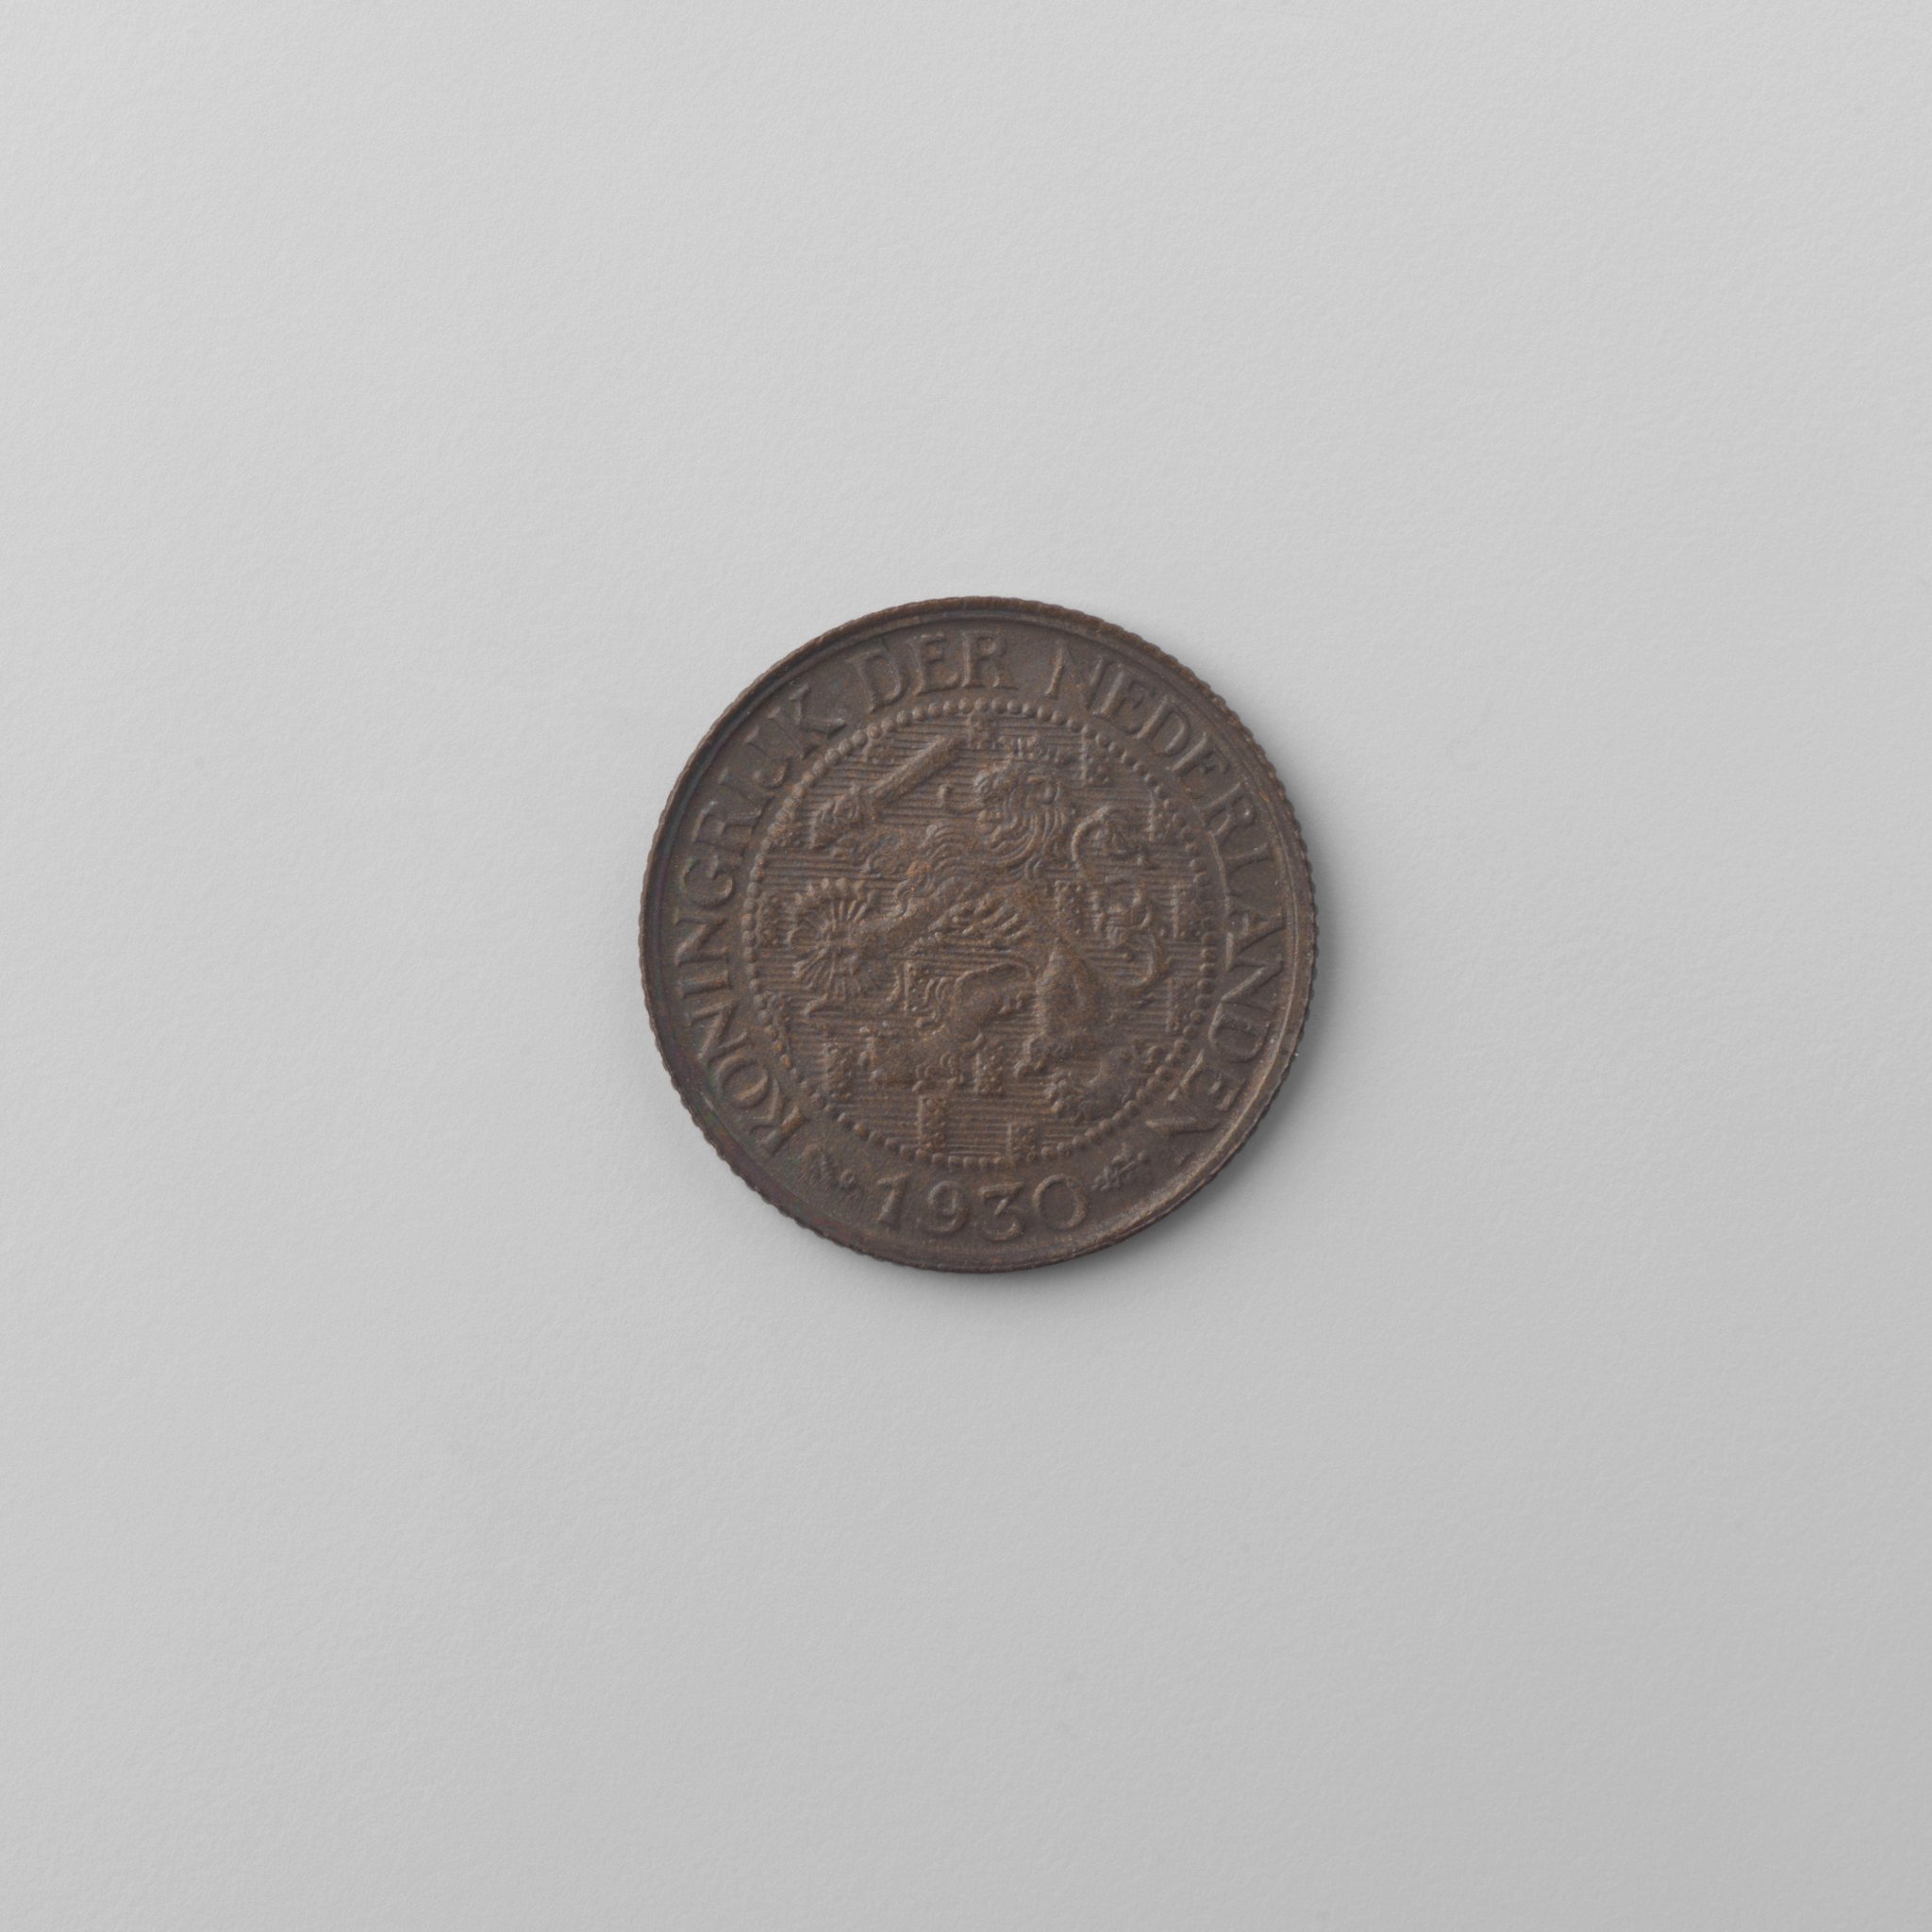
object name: coin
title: Nederland, cent,1930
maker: wilhelmina of the netherlands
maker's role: print maker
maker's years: 1880-1962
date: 1930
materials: bronze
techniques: striking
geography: utrecht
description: Bronzen munt. Voorzijde: in een veld rijkswapen. Jaartal onderaan in omschrift. Keerzijde: binnen twee samengebonden oranjetakken waarde-aanduiding 1 cent. Kartelrand.